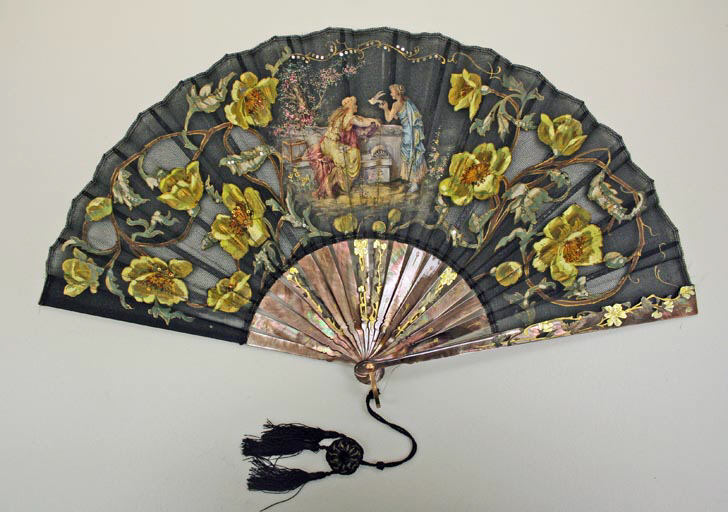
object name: fan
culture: american or european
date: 1880-1900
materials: gouache, metal, mother of pearl, silk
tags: birds,women,flowers